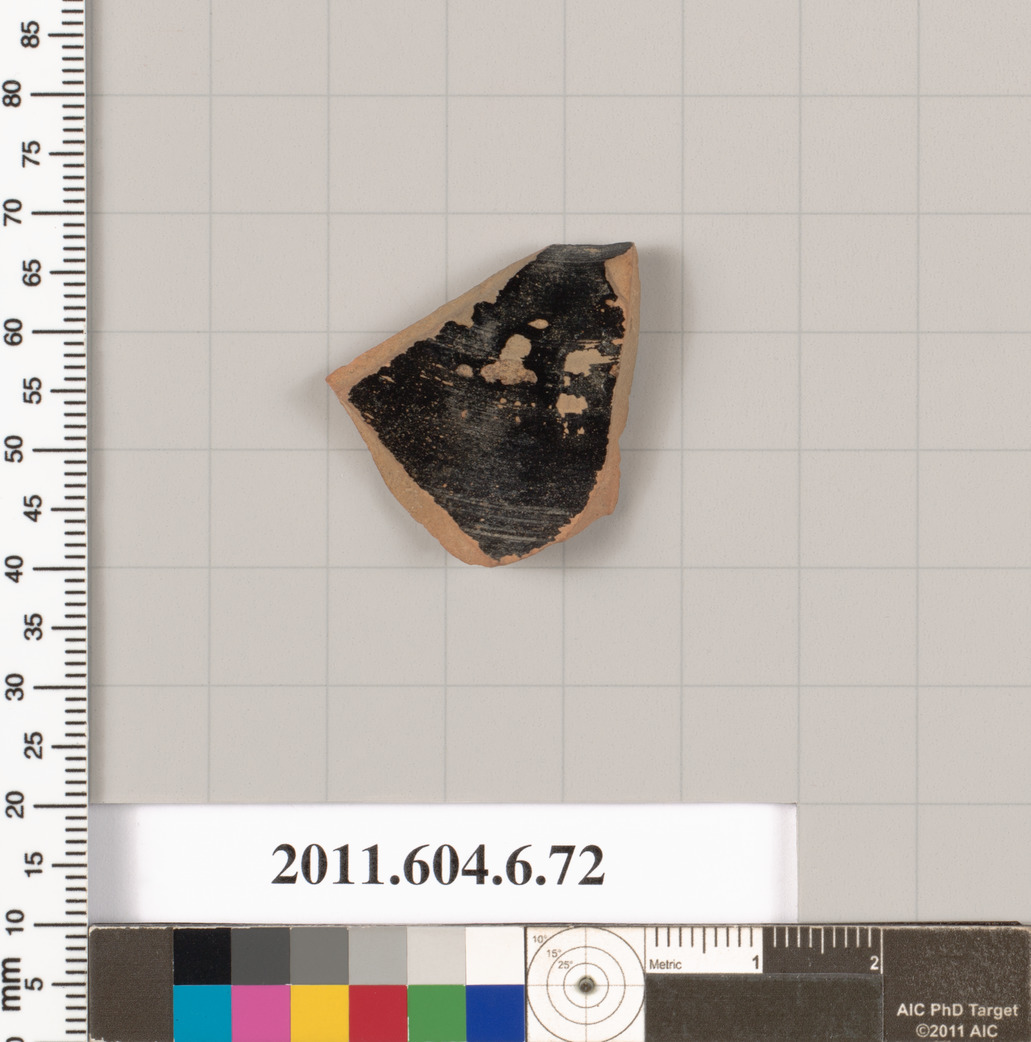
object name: undetermined shape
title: Terracotta fragment of an undetermined shape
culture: greek, attic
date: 600-401 BCE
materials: terracotta